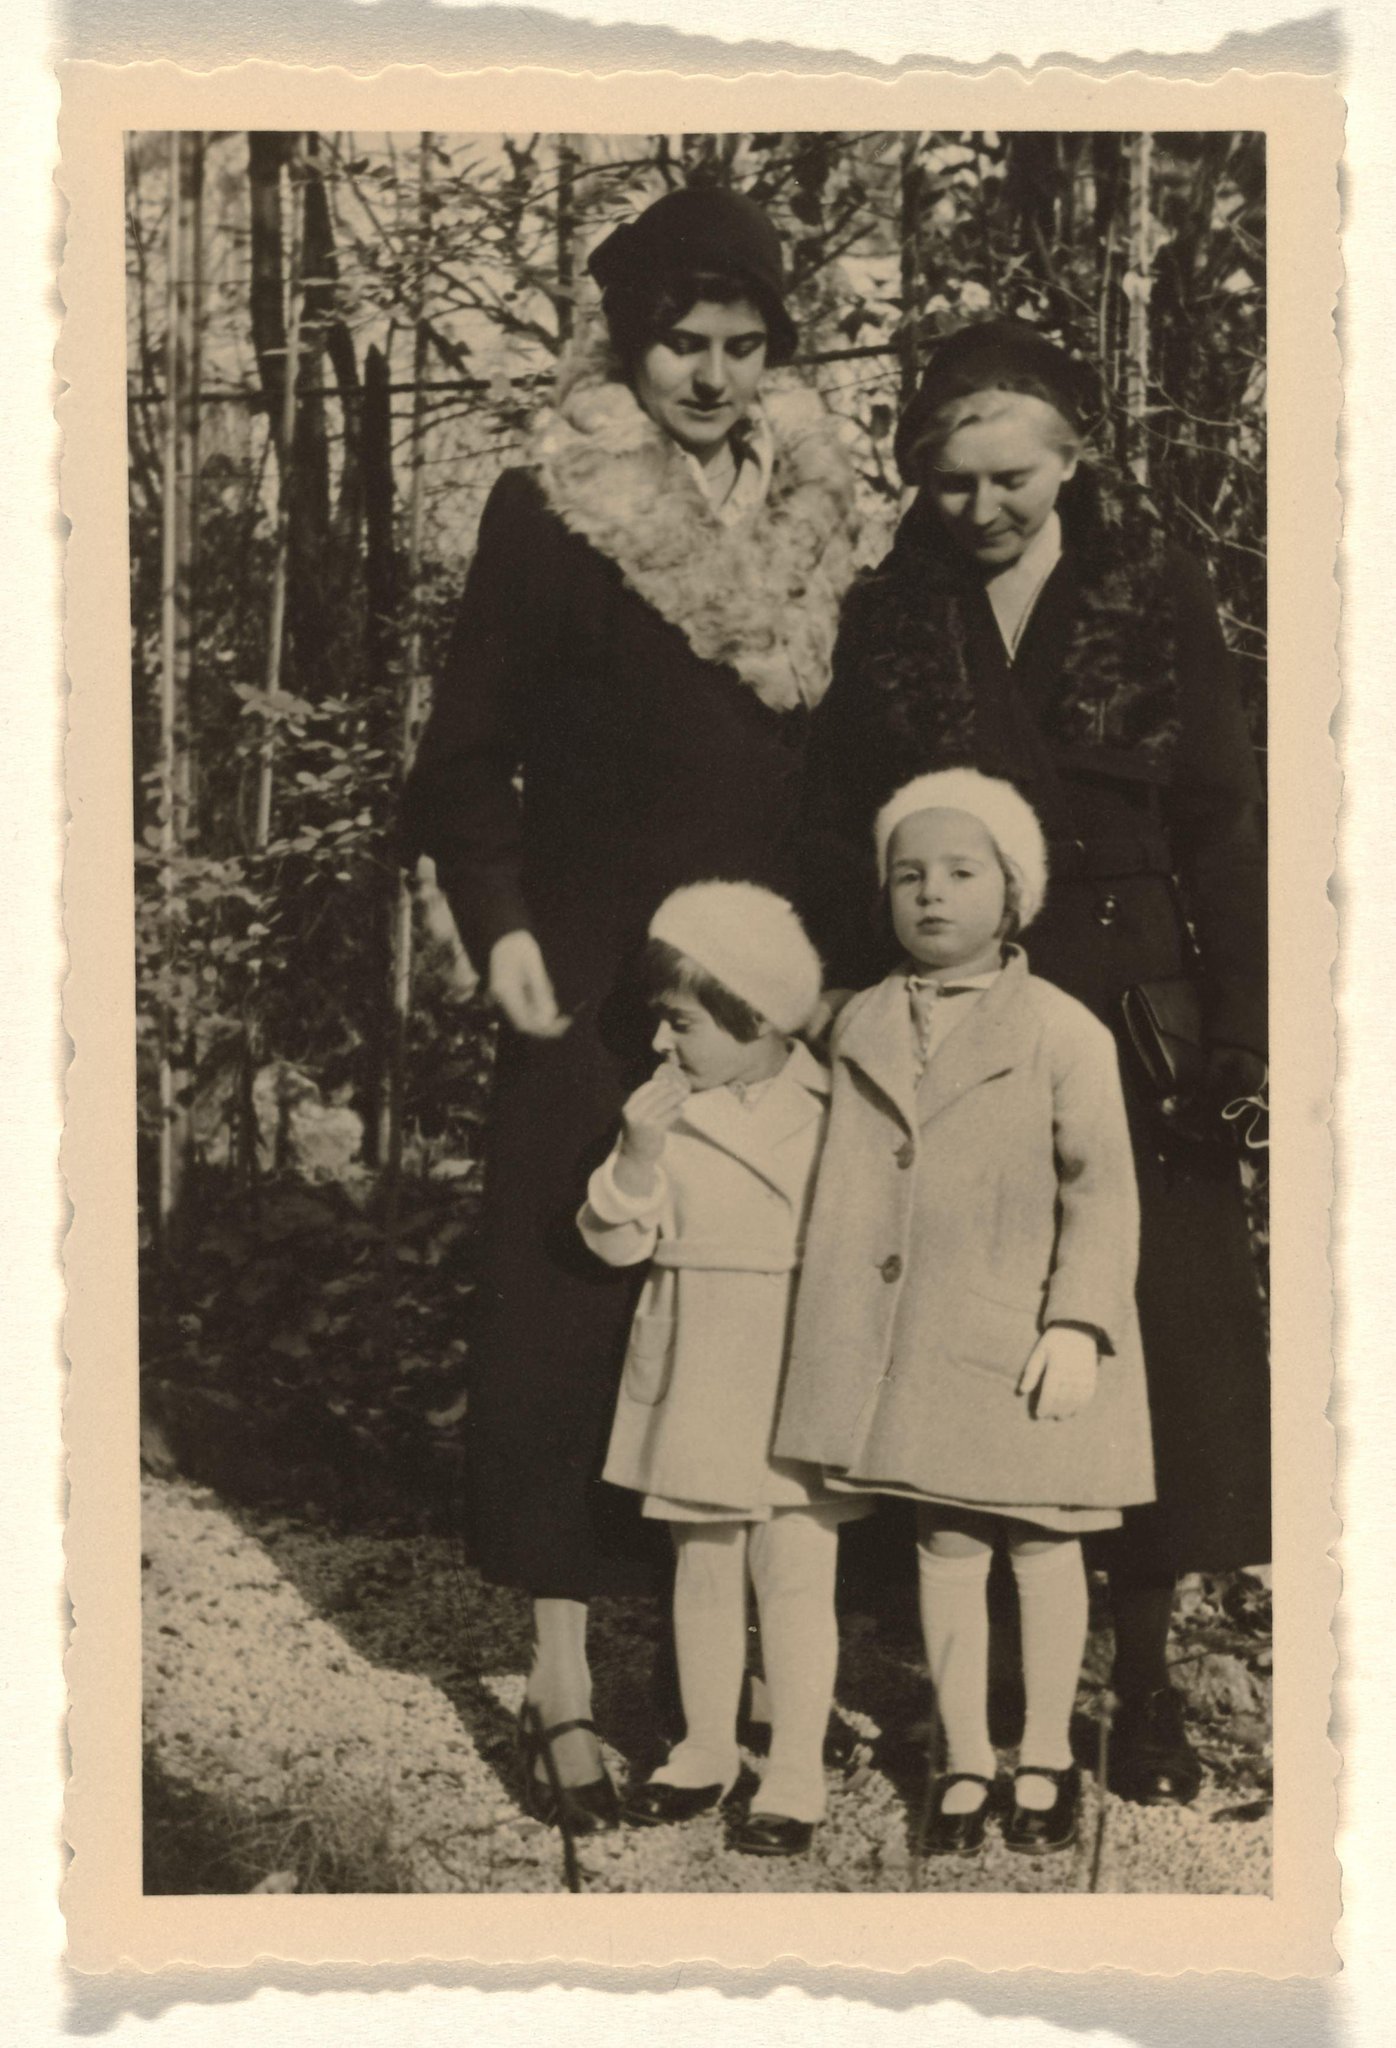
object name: photograph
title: Isabel Wachenheimer, twee onbekende vrouwen en een onbekend meisje tijdens wintersportvakantie in januari 1933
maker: Anonymous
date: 1901-1933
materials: photographic support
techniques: gelatin silver print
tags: isabel wachenheimer-elon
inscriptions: date: ‘Würt.32-33.’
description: Dit object is onderdeel van de nalatenschap van Isabel Elon-Wachenheimer (1928-2010). Tot haar overlijden behoorde het samen met de andere objecten uit de nalatenschap tot haar privédomein van Isabel Wachenheimer. In die particuliere context zijn deze objecten tezamen en individueel aandenkens - aan de jeugd, ouders en familie van Isabel Wachenheimer vóór en tijdens de Shoah en aan haar leven na de Tweede Wereldoorlog. Isabel Wachenheimer, die van juni 1943 tot mei 1945 gevangen zat in Kamp Westerbork, Theresienstadt, Auschwitz, Lenzing a/d Oberdonau (een buitenkamp van Mauthausen), overleefde de Shoah. Haar ouders – Eugène Wachenheimer en Else Wachenheimer-Moos - werden op 14 oktober 1944 in Auschwitz-Birkenau vermoord.